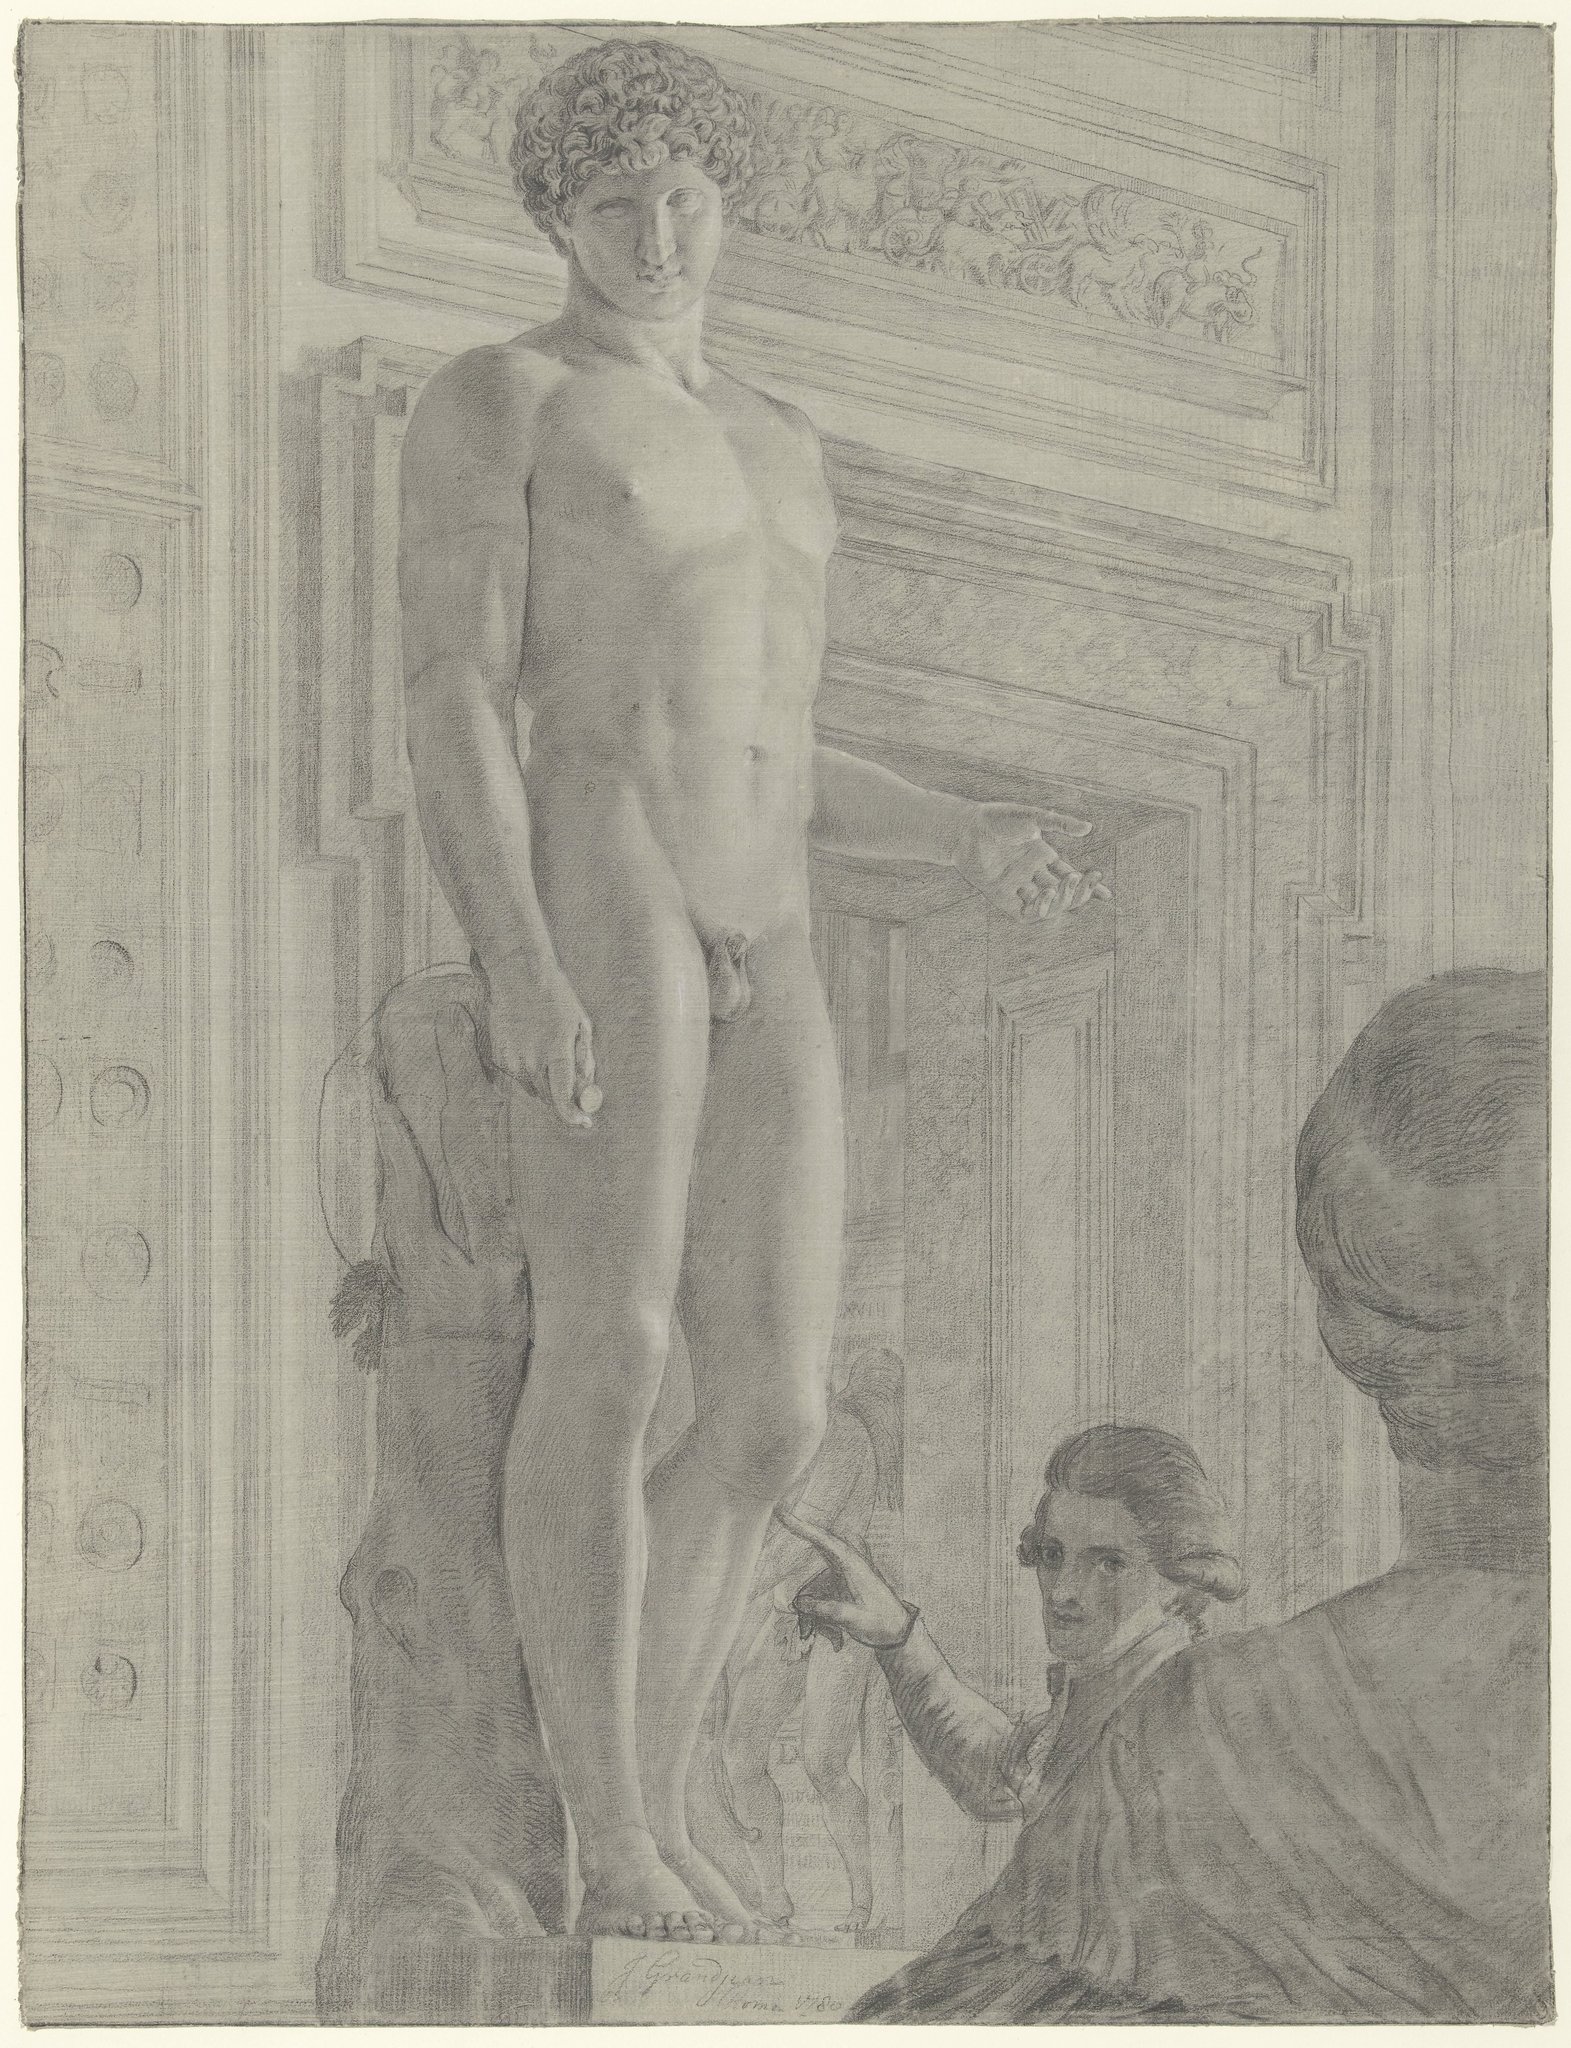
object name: drawing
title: Beeld van Antinous Albanie in het Capitolijns Museum te Rome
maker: jean grandjean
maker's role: draughtsman, print maker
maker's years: 1752-1781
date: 1780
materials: chalk, paper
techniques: brush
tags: names of artefacts and man-made objects (buildings excluded), the (nude) human figure; 'corpo humano' (ripa), piece of sculpture, reproduction of a piece of sculpture, permanent exhibition, museum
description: De Deense oriëntalist en theoloog Andreas Christian Hviid bij de zogenaamde Antinous Albani in het Capitolijns Museum te Rome.